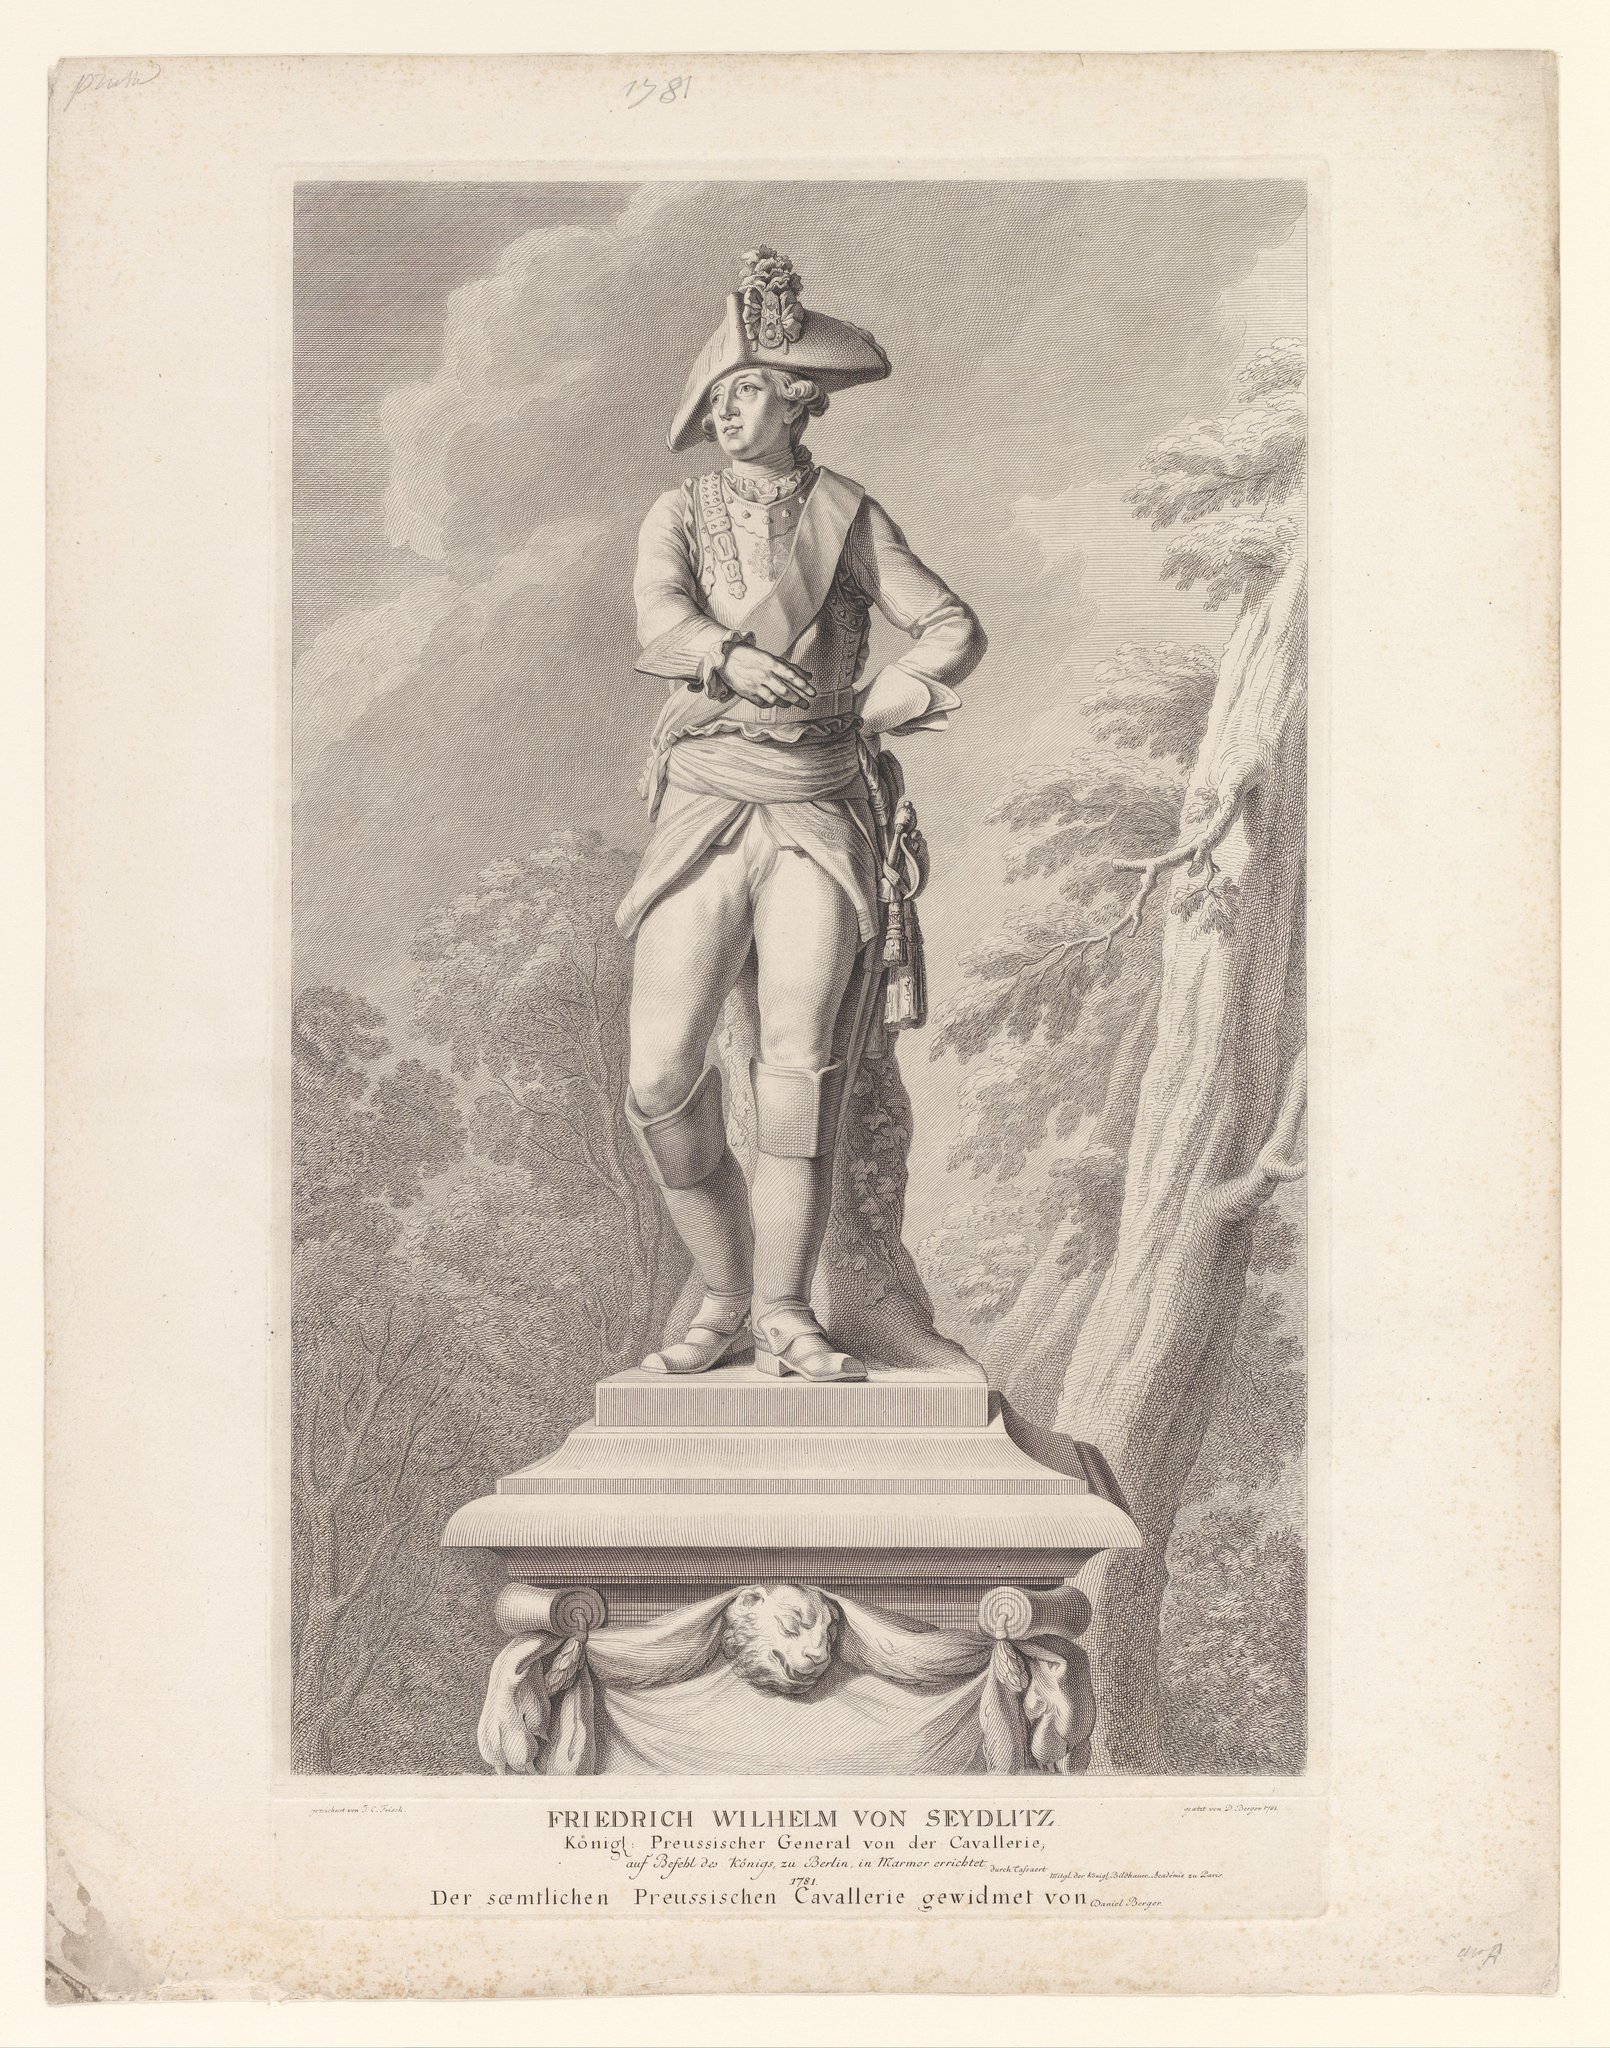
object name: print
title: Standbeeld van Friedrich Wilhelm, Freiherr von Seydlitz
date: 1781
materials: paper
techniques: engraving, etching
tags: kalkar, historical persons, monument, statue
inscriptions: collector's mark: Lugt 2228